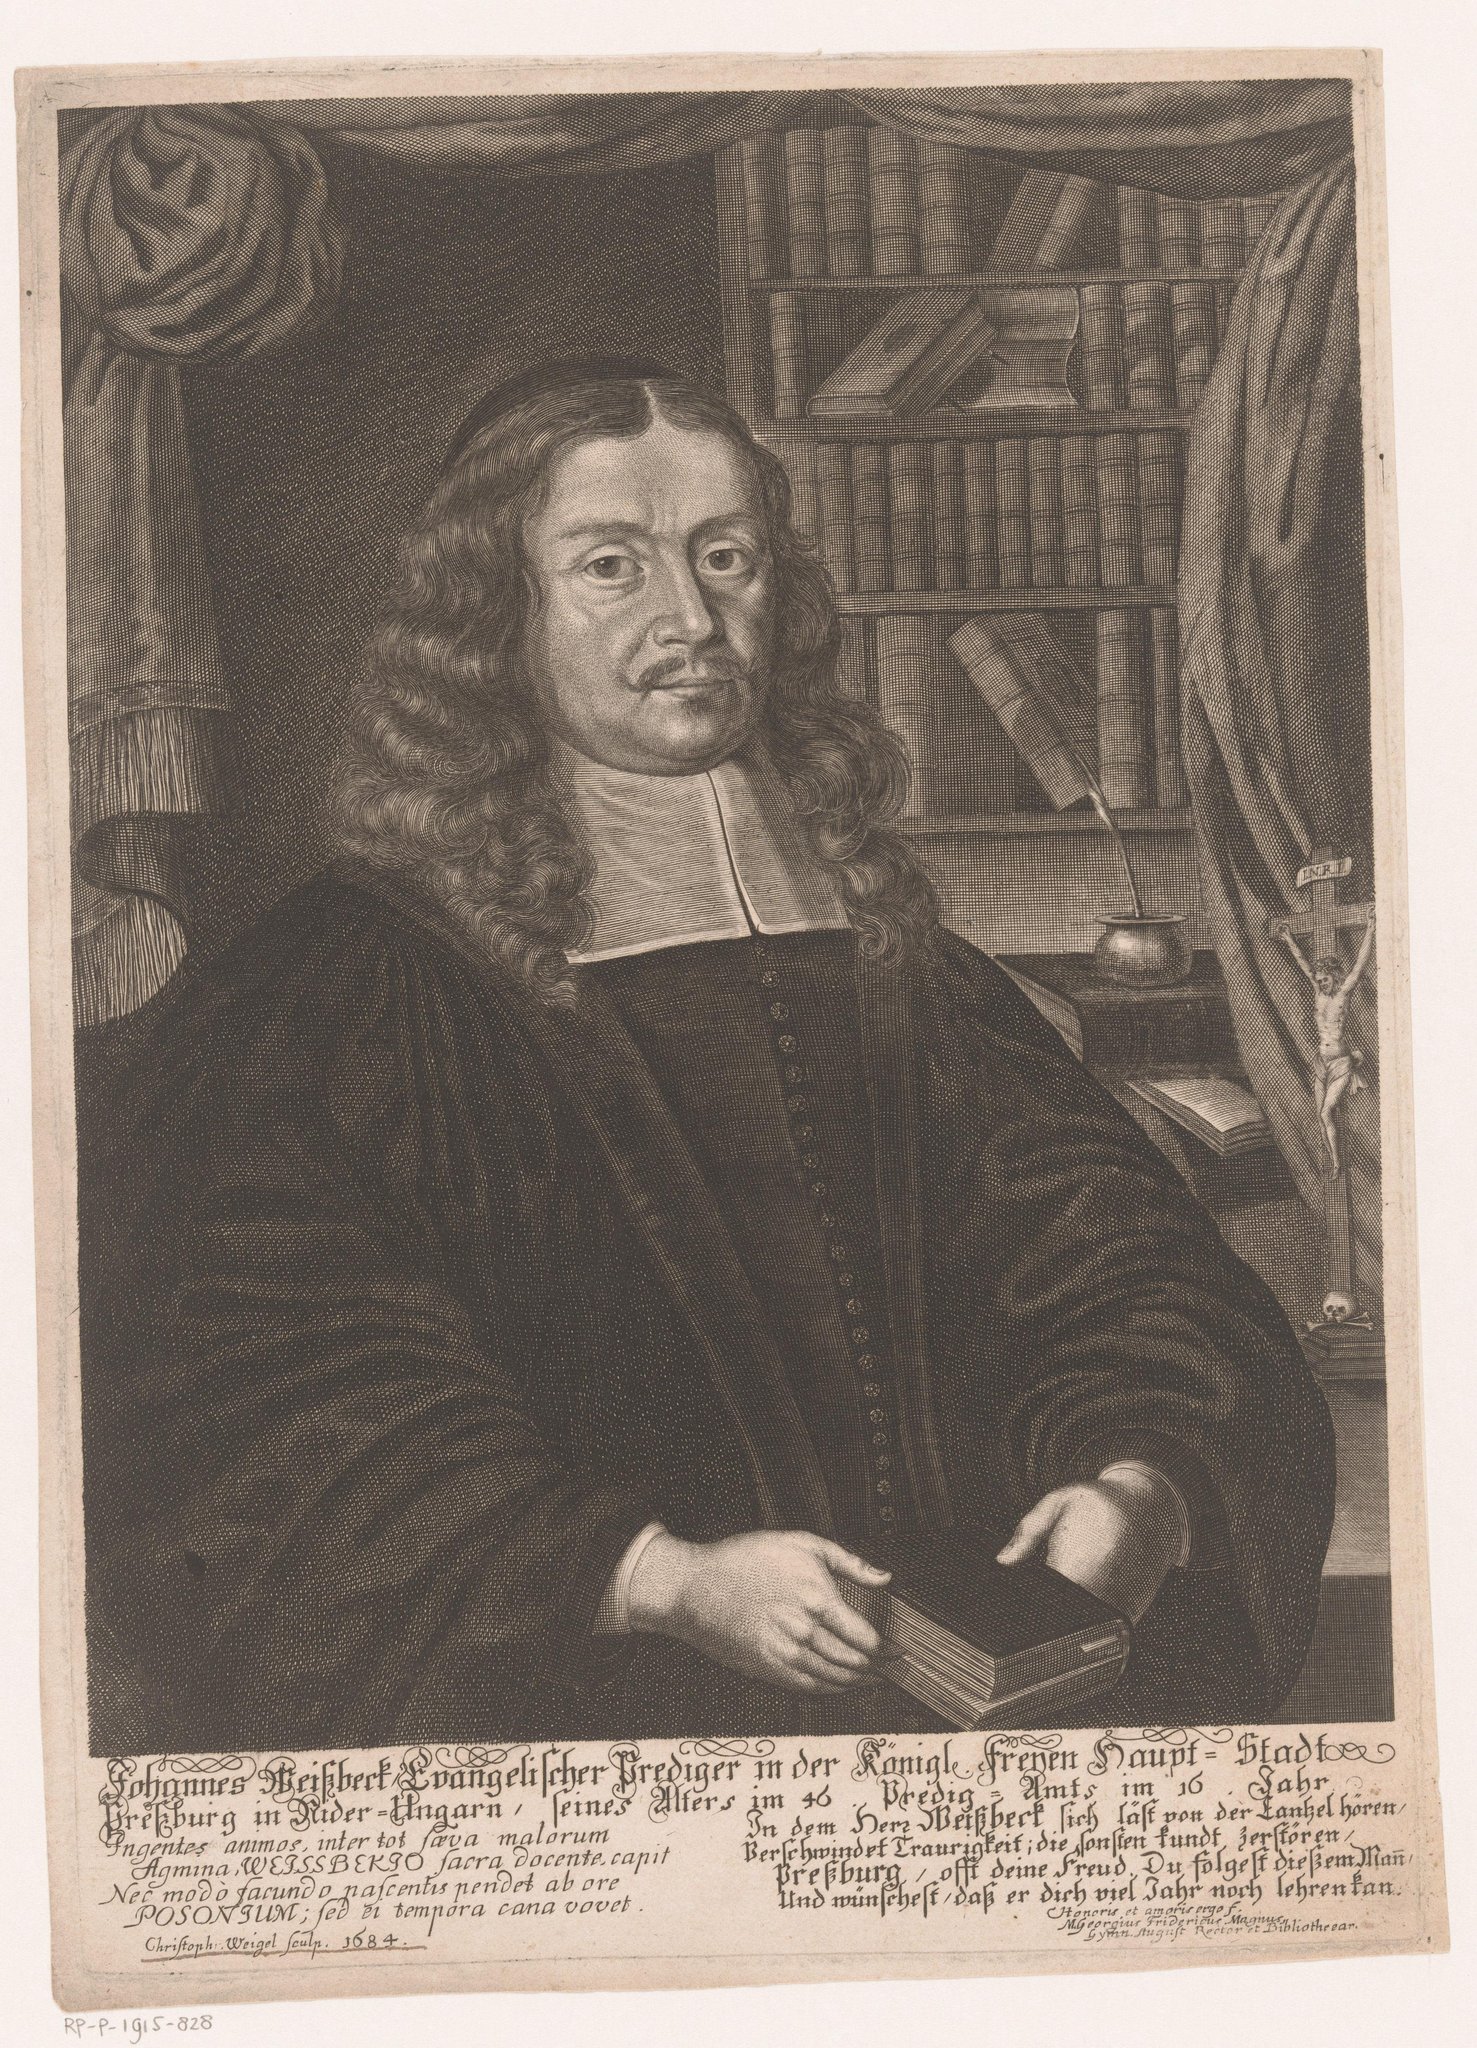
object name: print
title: Portret van Johann Weissbeck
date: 1684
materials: paper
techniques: engraving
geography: germany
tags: bookshelves, ink-well, historical persons, crucifix ~ personal devotion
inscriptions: collector's mark: Lugt 2233